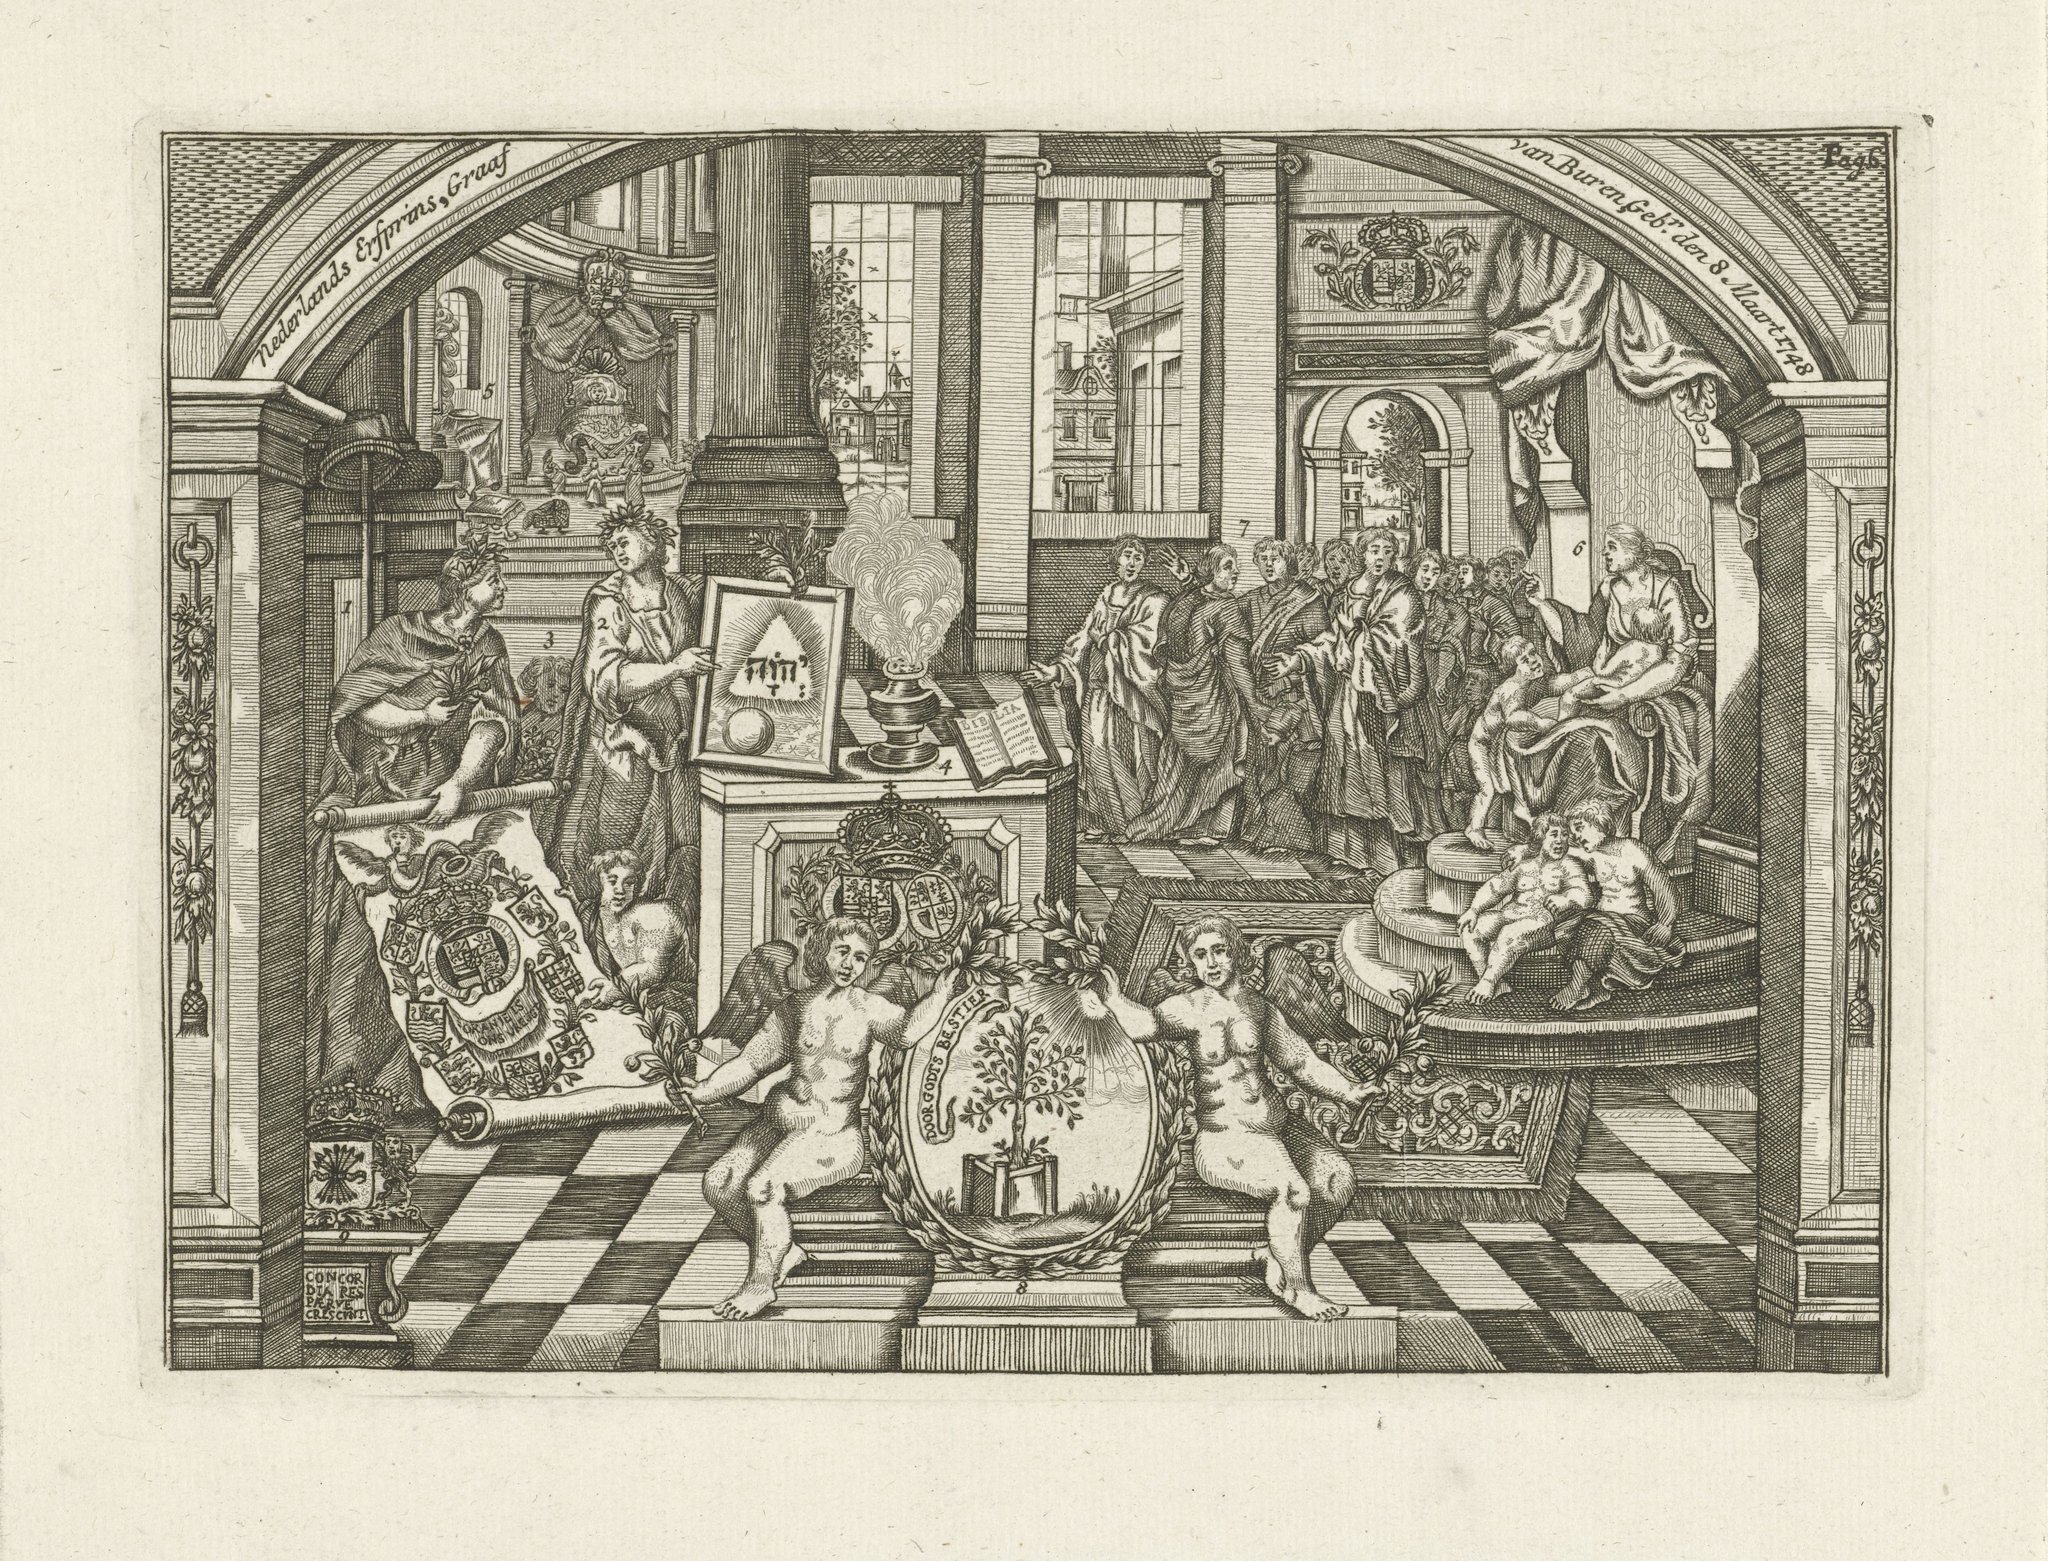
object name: print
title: Nederlands Erfprins Graaf van Buren Gebr. den 8 Maart 1748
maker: gerrit sibersma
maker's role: print maker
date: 1748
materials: paper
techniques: engraving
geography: northern netherlands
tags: william v (prince of orange), charity, 'caritas'; 'carità' (ripa) ~ one of the three theological virtues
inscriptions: collector's mark: Lugt 2228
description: Allegorie op de geboorte van Willem V, de graaf van Buren, prins van Oranje, 8 maart 1748. Interieur met links de Vrijheid en de Wijsheid, rechts de Liefde op de troon, centraal twee putti met een embleem met de Oranjeboom. Gemerkt rechtsboven: Pag. 6.